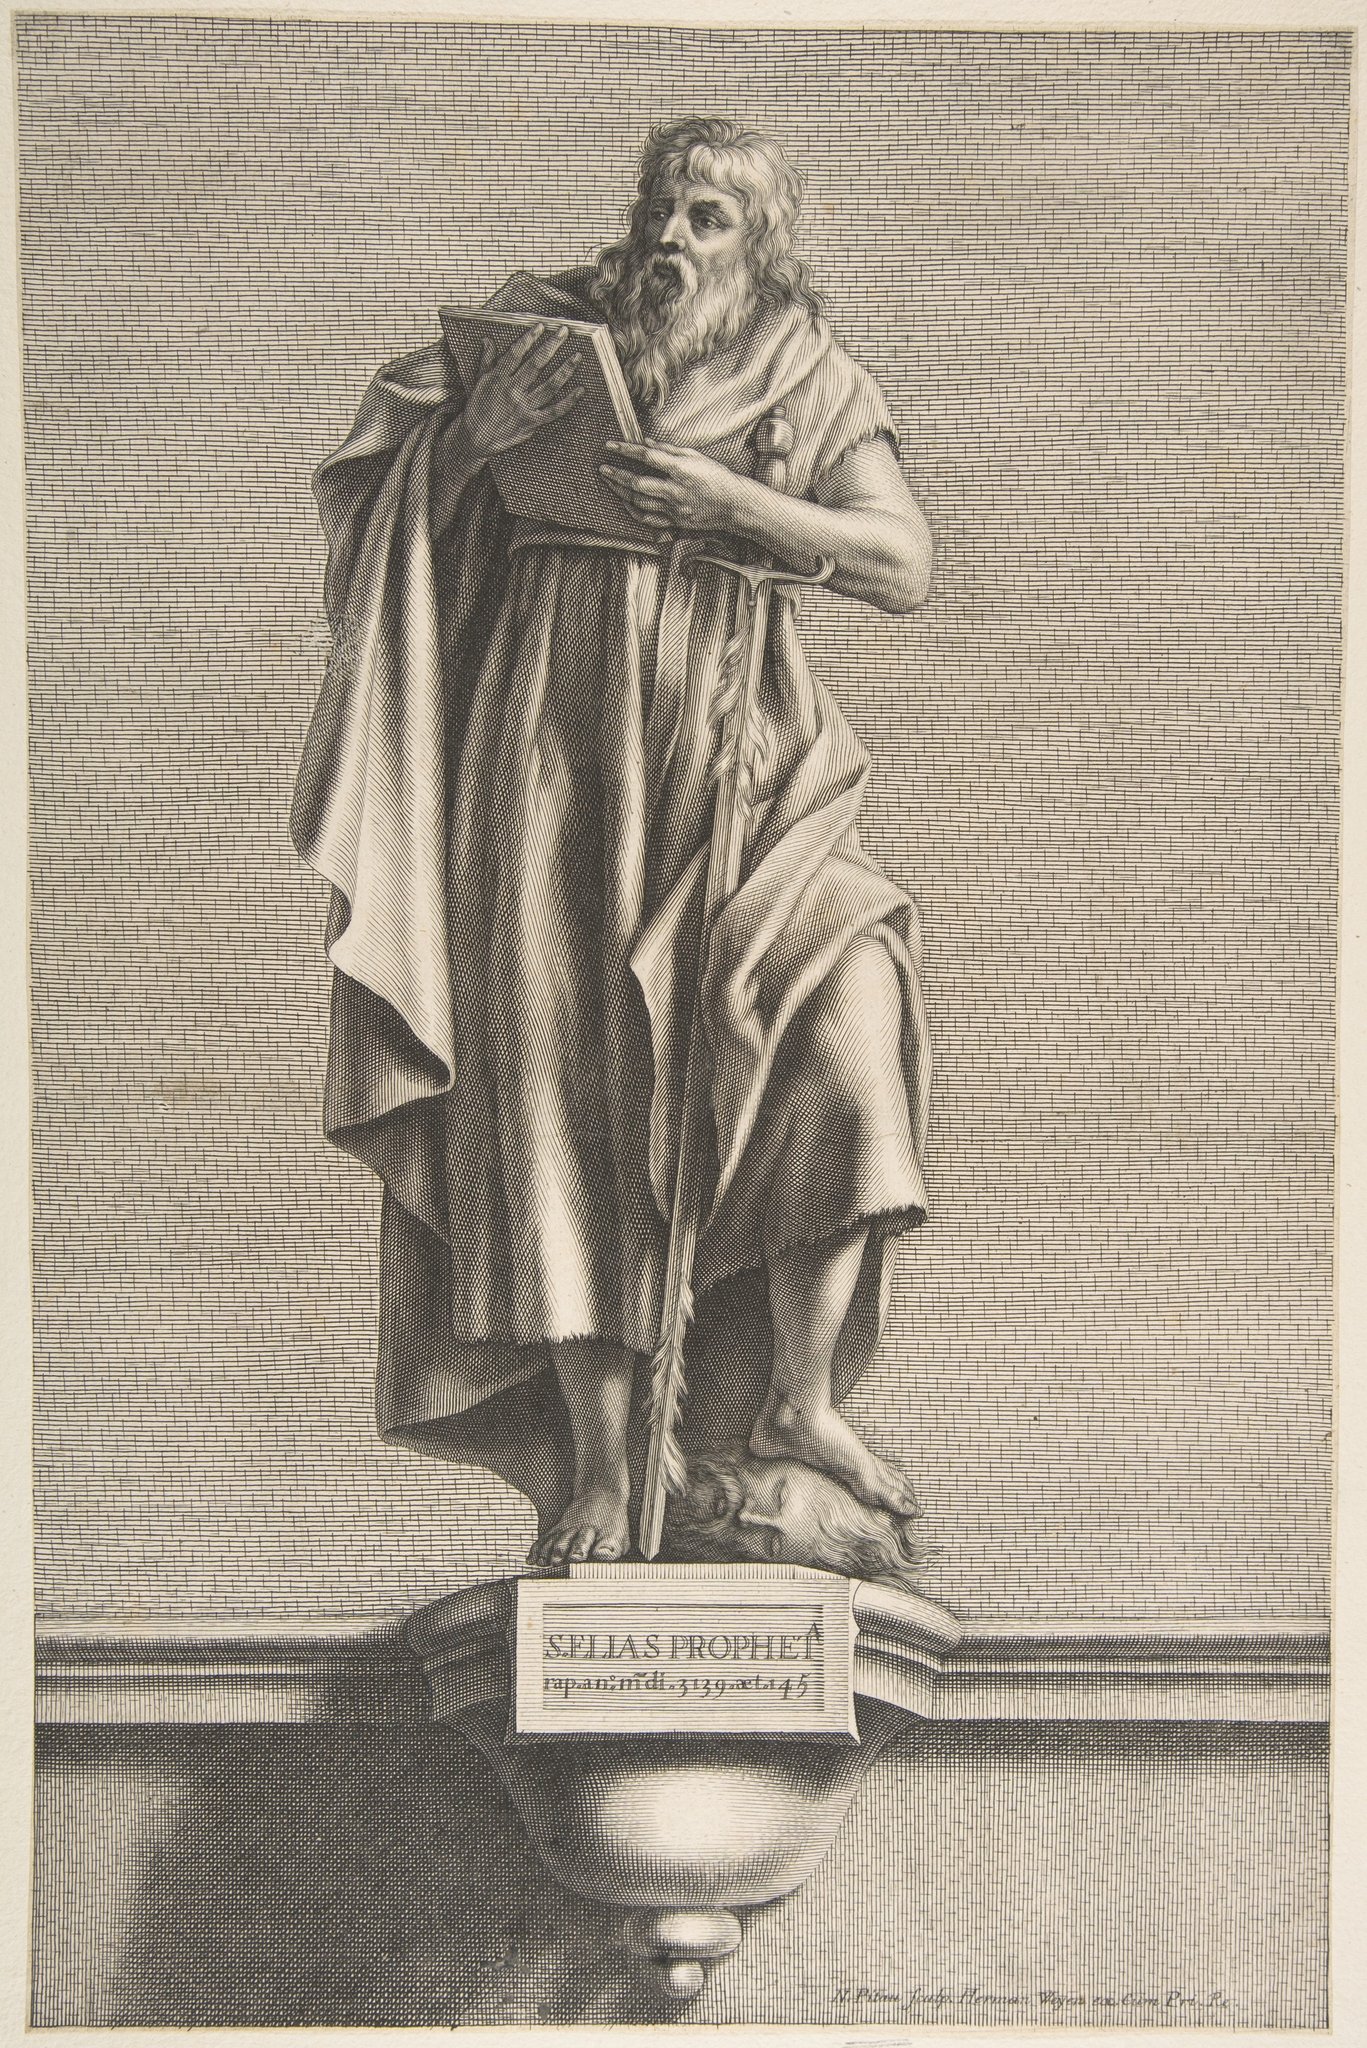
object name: print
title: The Prophet Elias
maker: nicolas pitau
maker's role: artist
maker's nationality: french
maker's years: 1670-1724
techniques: engraving, etching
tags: men